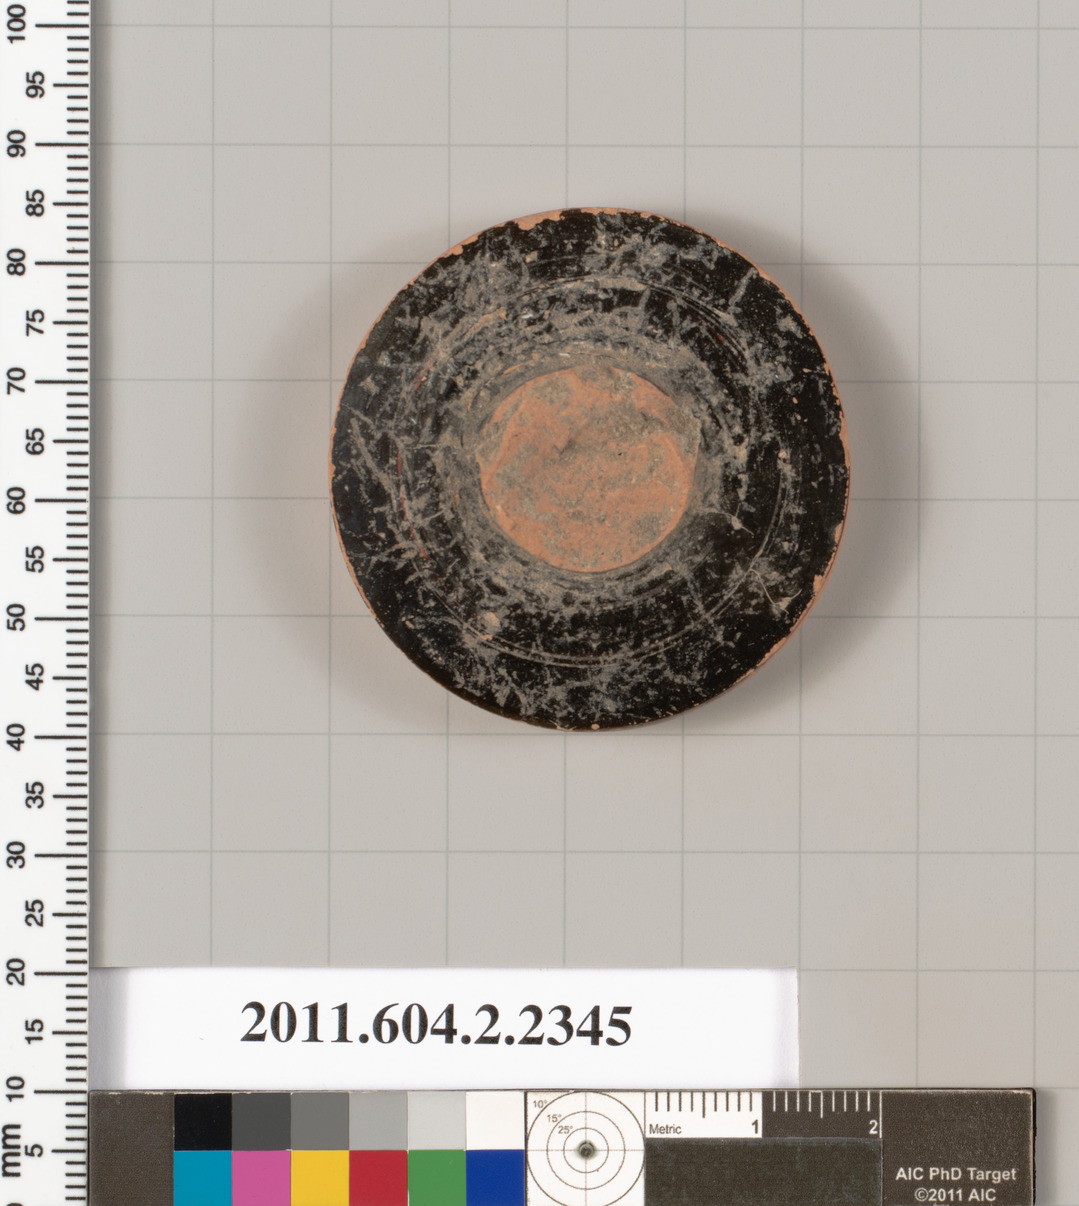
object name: lekythos fragment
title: Terracotta fragment of a lekythos (oil flask)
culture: greek, attic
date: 600-401 BCE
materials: terracotta